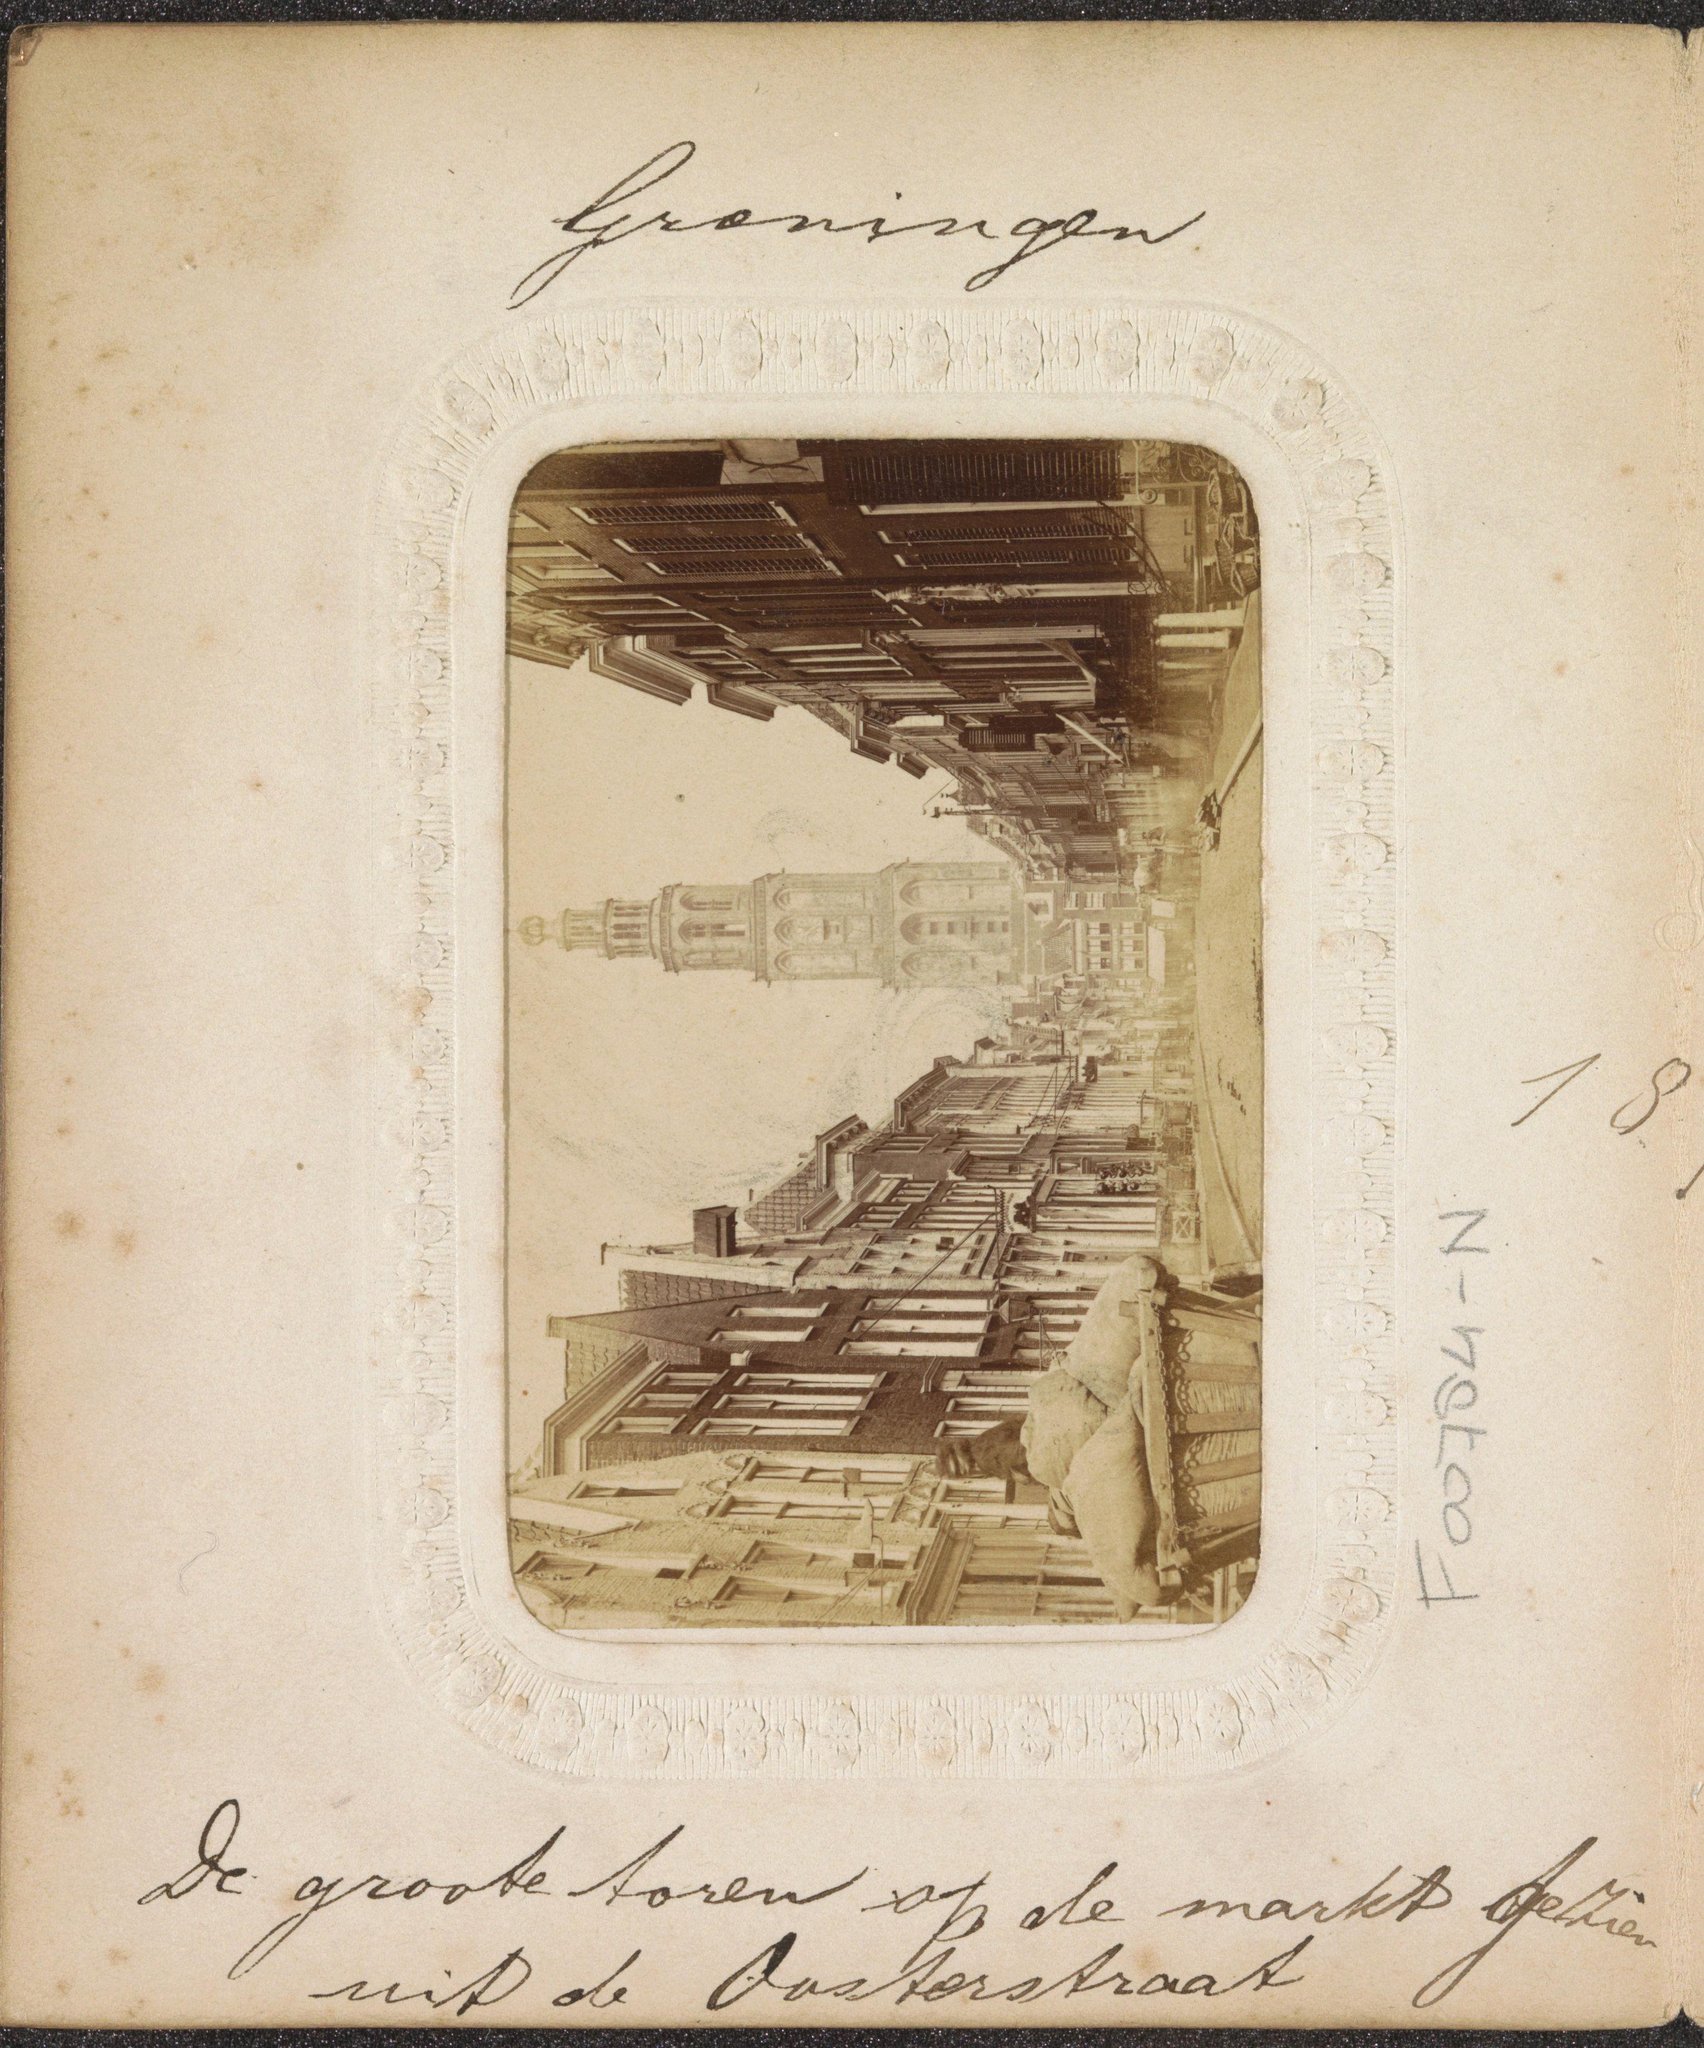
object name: carte de visite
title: De groote toren op de markt gezien uit de Oosterstraat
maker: Anonymous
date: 1871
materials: cardboard, paper, photographic support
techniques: albumen print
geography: groningen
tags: street (+ city(-scape) with figures, staffage), parts of church exterior and annexes: tower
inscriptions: name: ‘Egbert de Vries’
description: Onderdeel van Fotoalbum met bezienswaardigheden in Nederlandse, Belgische en Duitse steden.